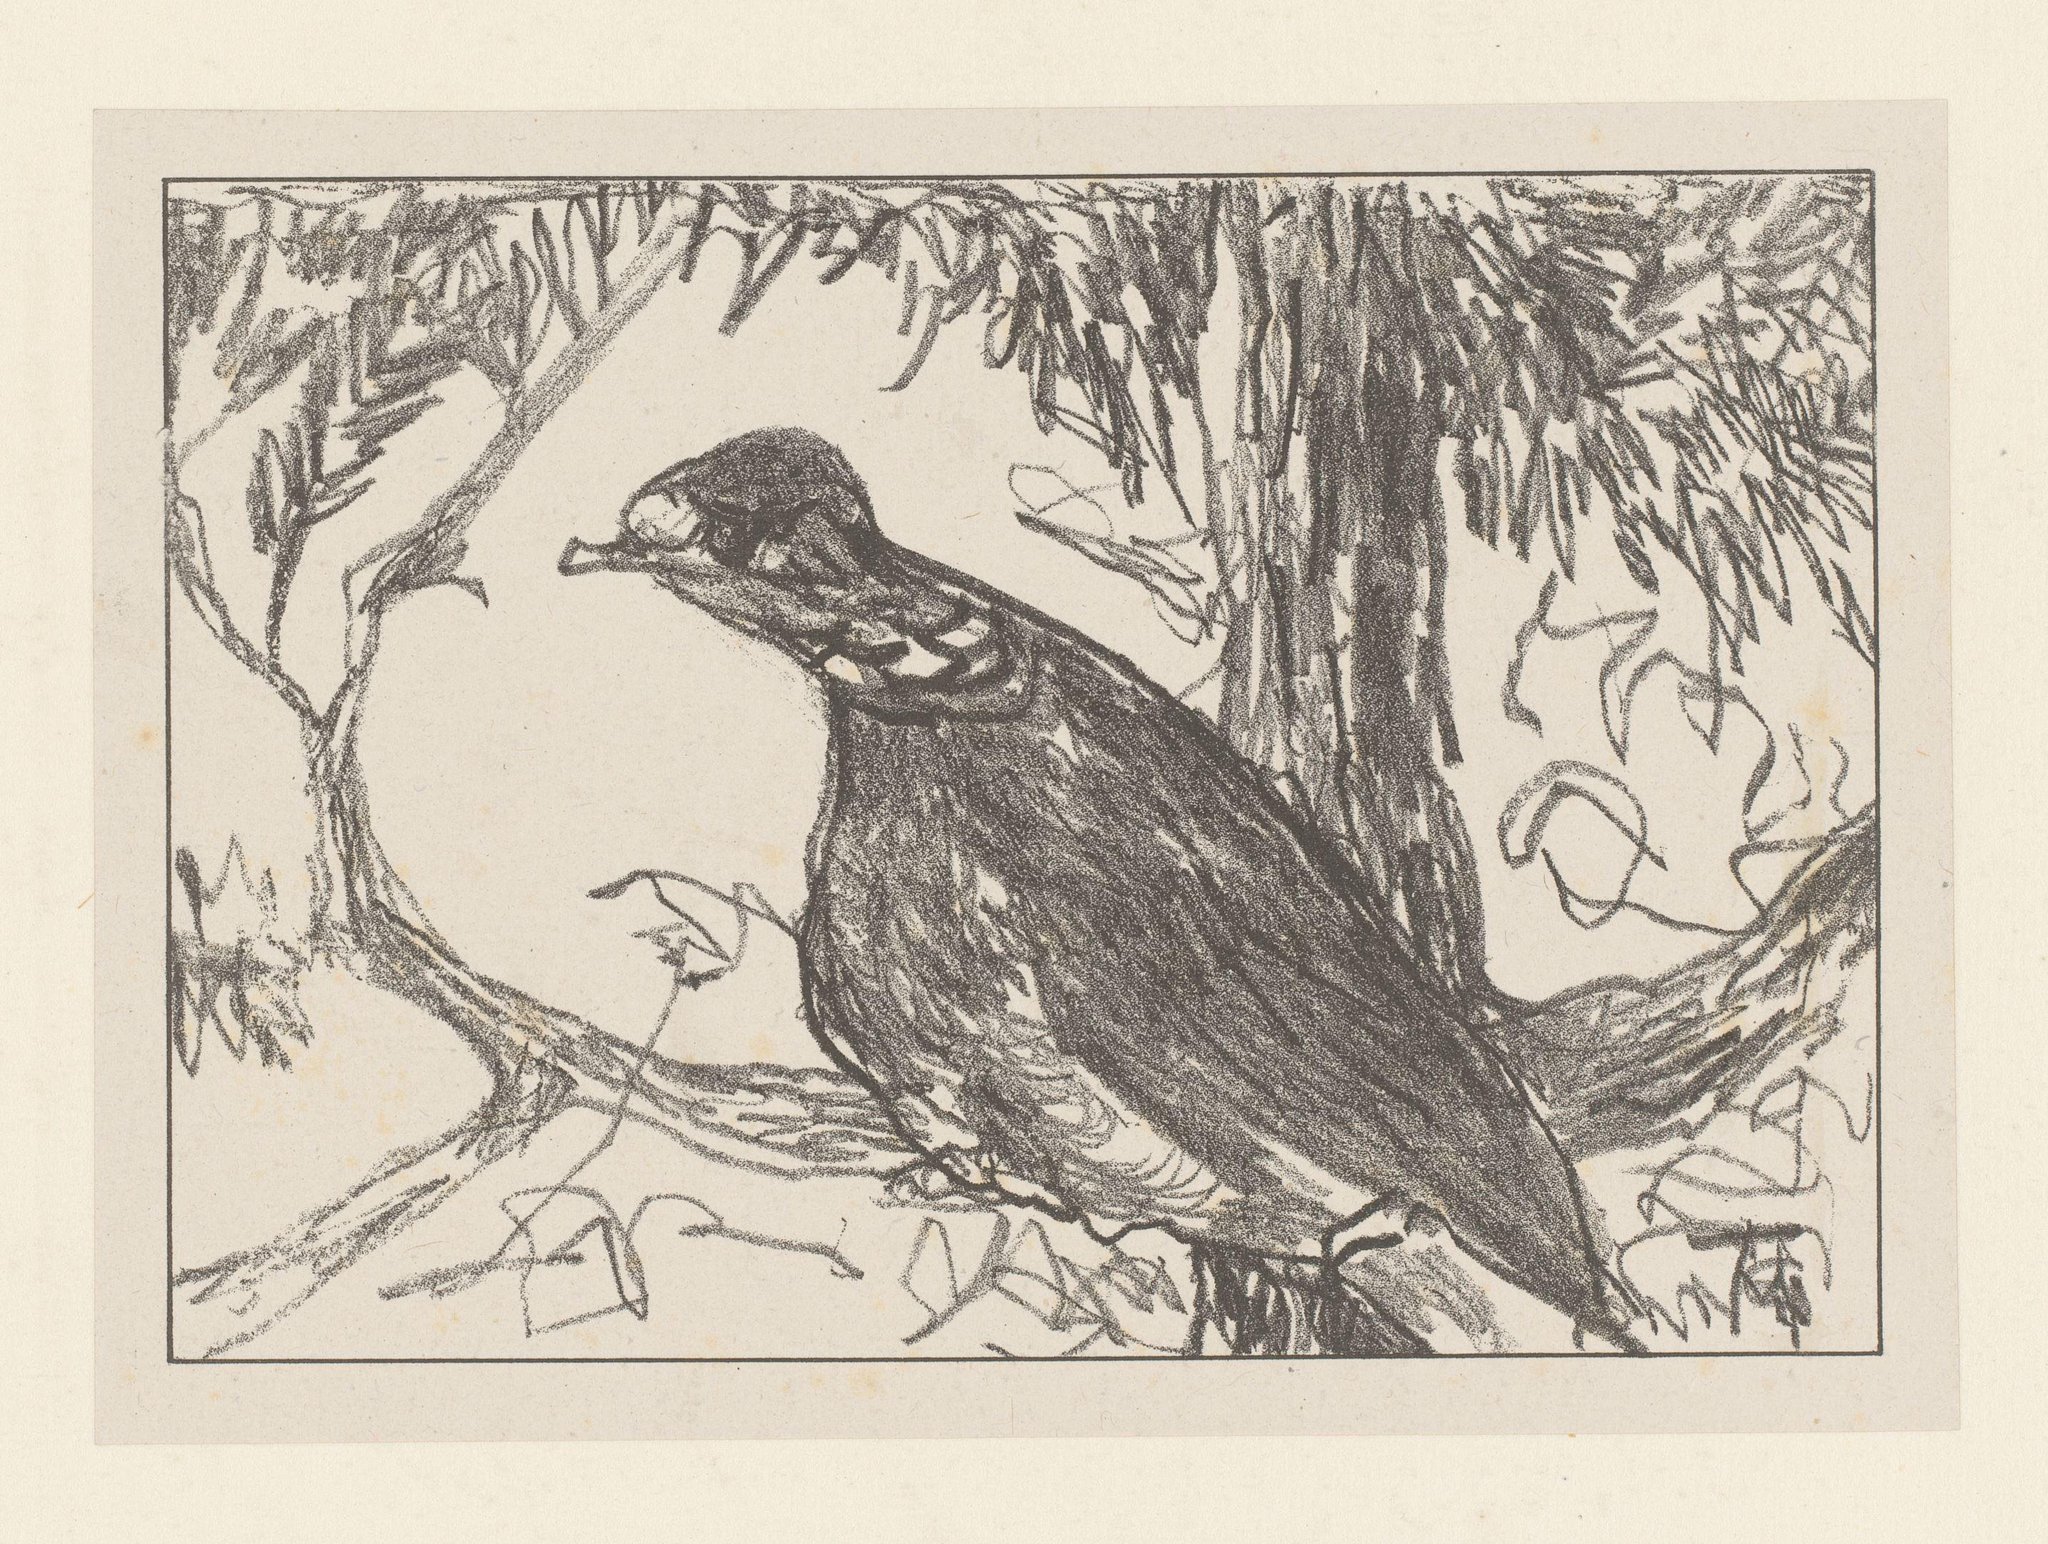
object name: print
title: Houtduif in boom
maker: theo van hoytema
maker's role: draughtsman, painter, print maker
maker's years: 1863-1917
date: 1874-1917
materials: paper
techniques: lithograph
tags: doves, pigeons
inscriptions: collector's mark: Lugt 2228, collector's mark: Lugt 4731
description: Prent is een proefdruk voor kalenderblad november 1918.